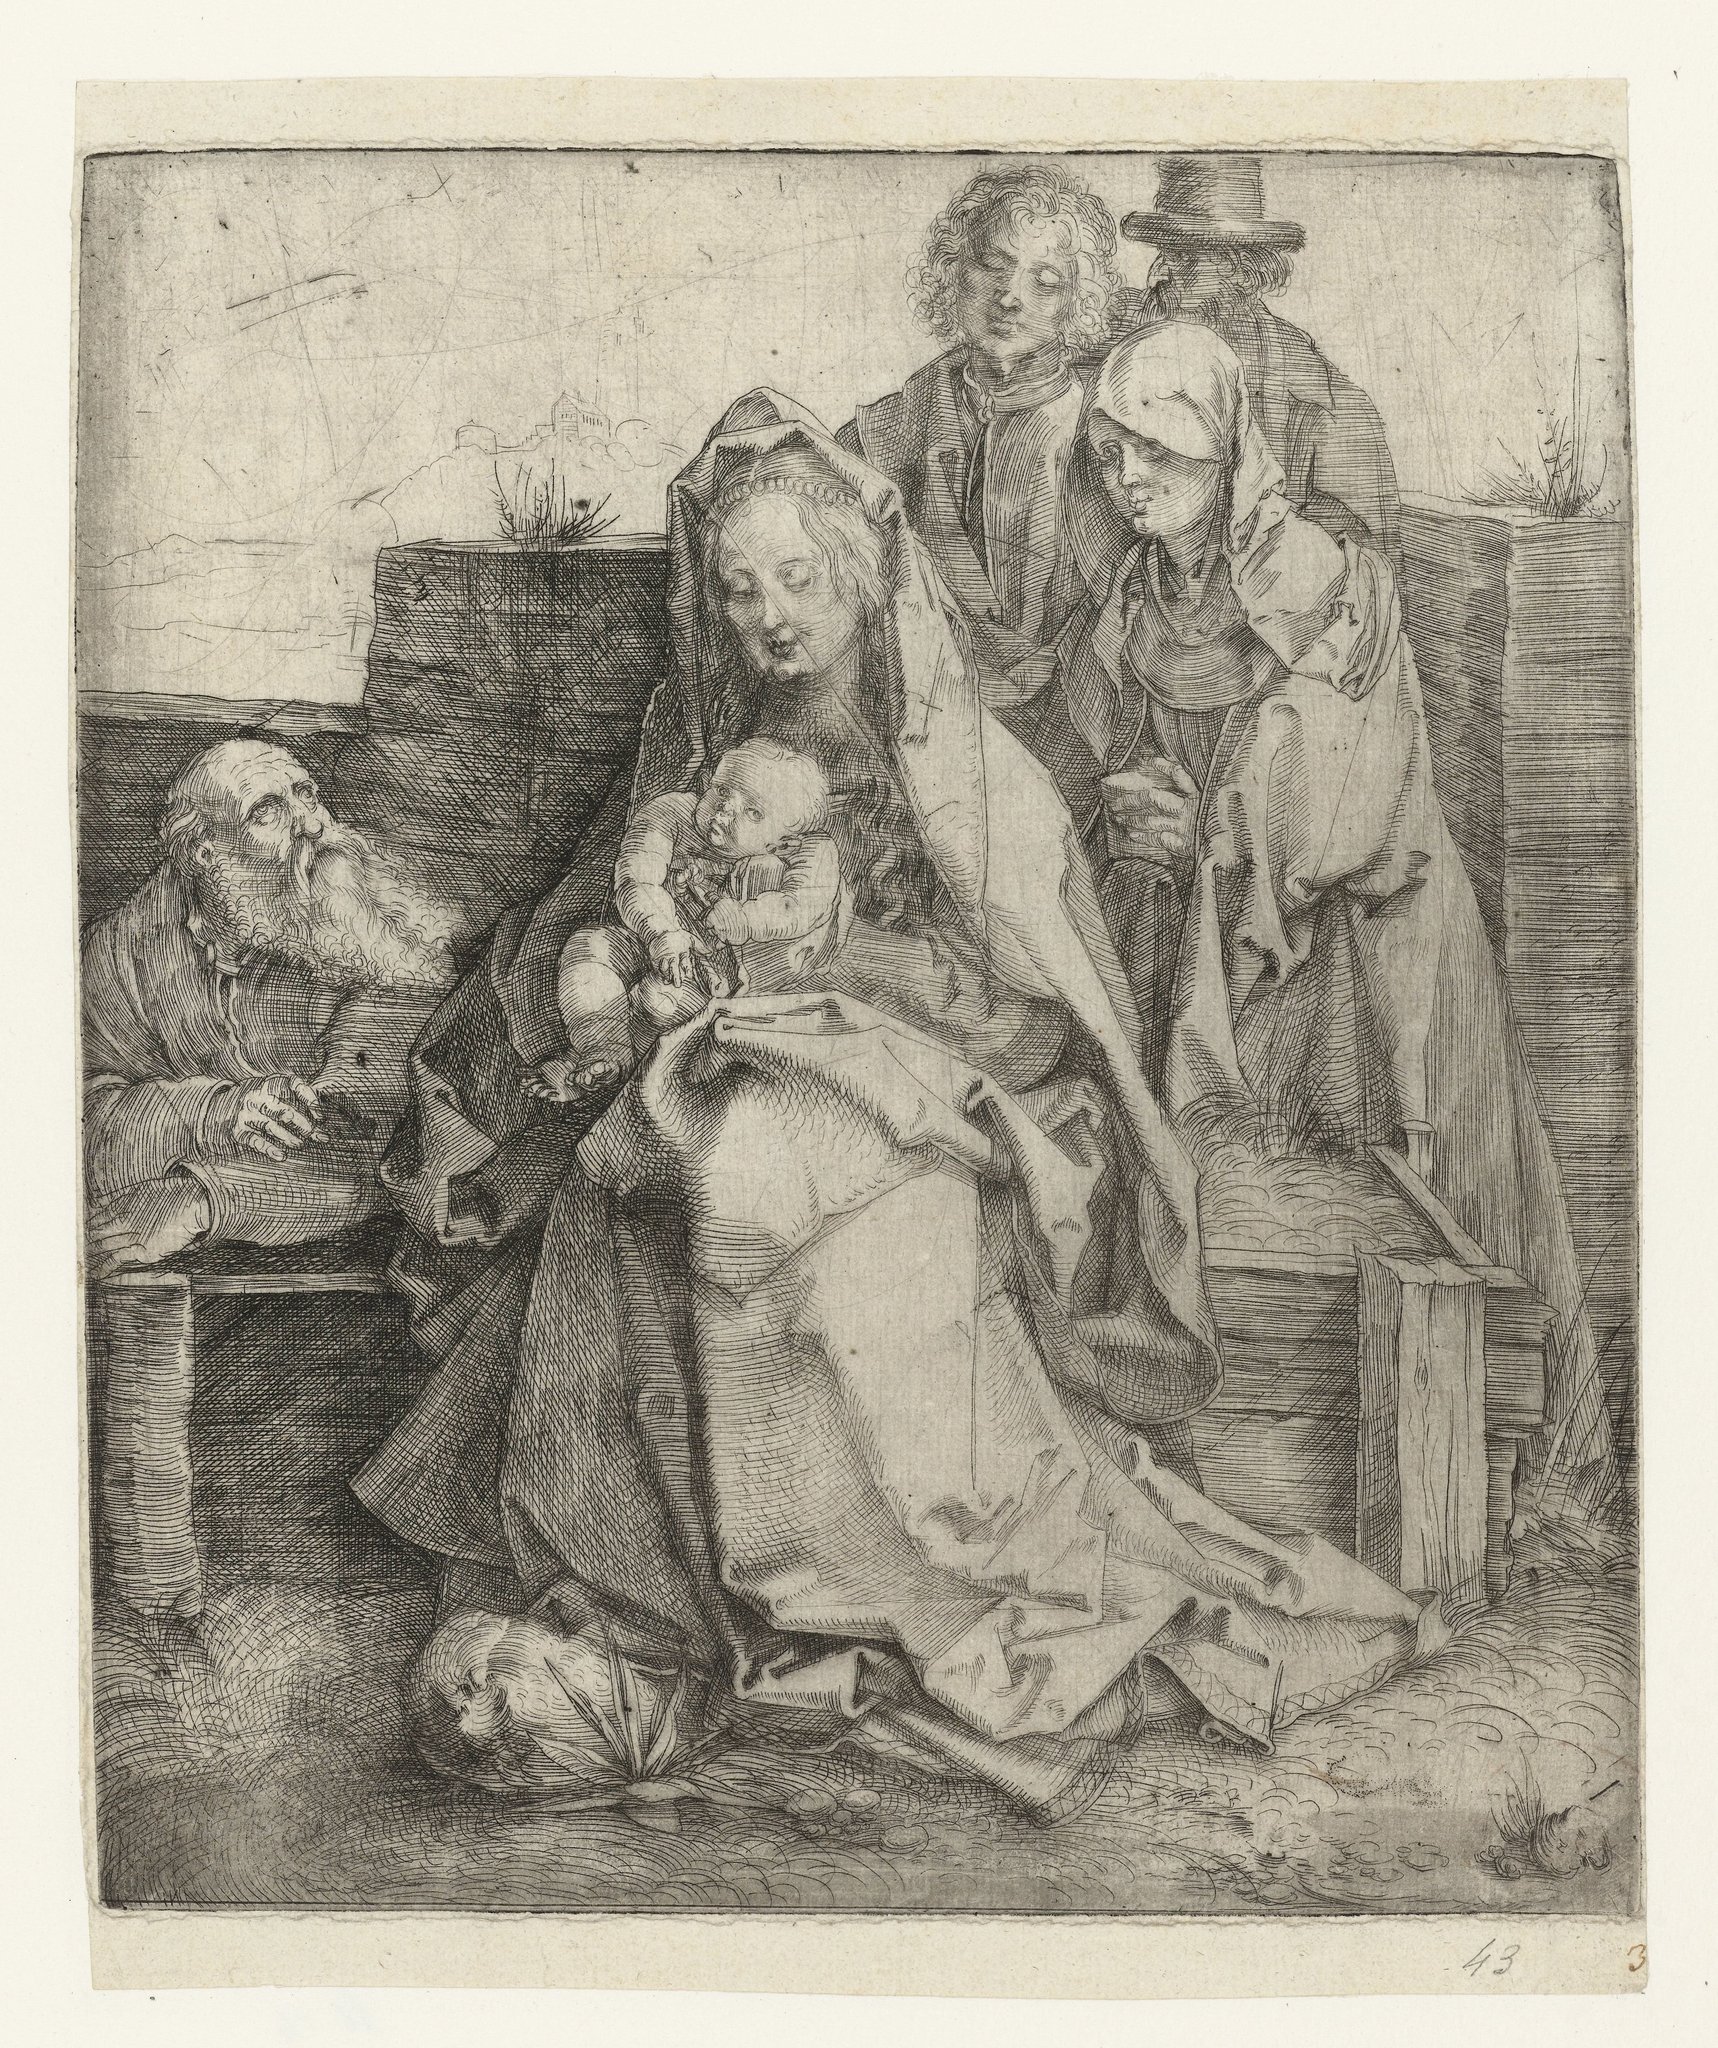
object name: print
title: De Heilige Familie met Johannes de Evangelist, Maria Magdalena en Nicodemus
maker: albrecht dürer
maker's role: draughtsman, painter, print maker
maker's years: 1471-1528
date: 1510-1515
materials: paper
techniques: drypoint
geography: nuremberg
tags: the apostle john the evangelist; possible attributes: book, cauldron, chalice with snake, eagle, palm, scroll, holy family with others, e.g.: anna, the penitent harlot mary magdalene; possible attributes: book (or scroll), crown, crown of thorns, crucifix, jar of ointment, mirror, musical instrument, palm-branch, rosary, scourge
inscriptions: collector's mark: Lugt 240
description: Maria zit op een houten bank met het Christuskind op schoot. Aan haar rechterzijde Jozef, achter haar Johannes de Evangelist, Maria Magdalena en Nicodemus.